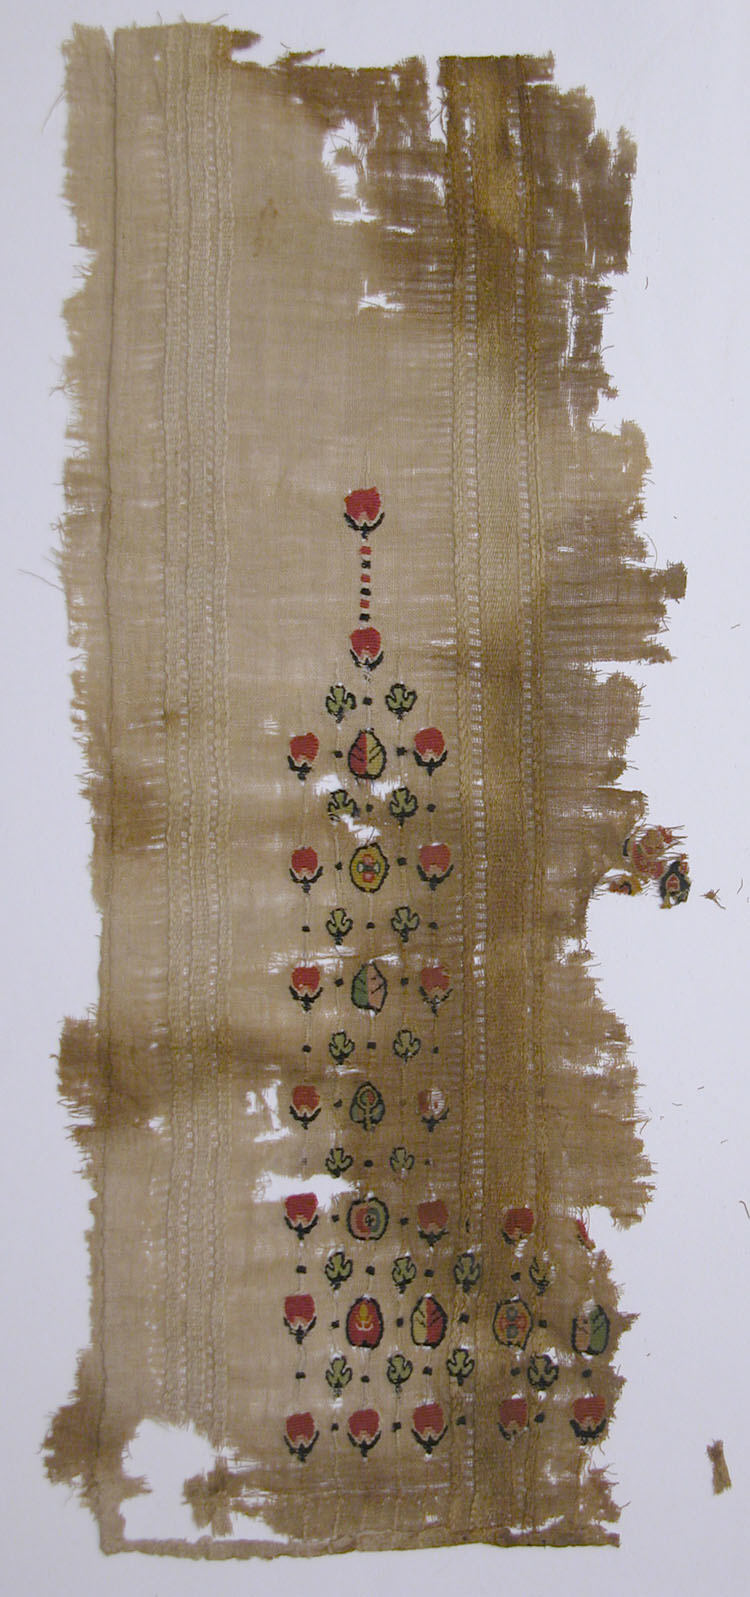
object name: textile fragment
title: Fragment with Scattered Pattern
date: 501-800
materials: linen, wool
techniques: weave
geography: egypt